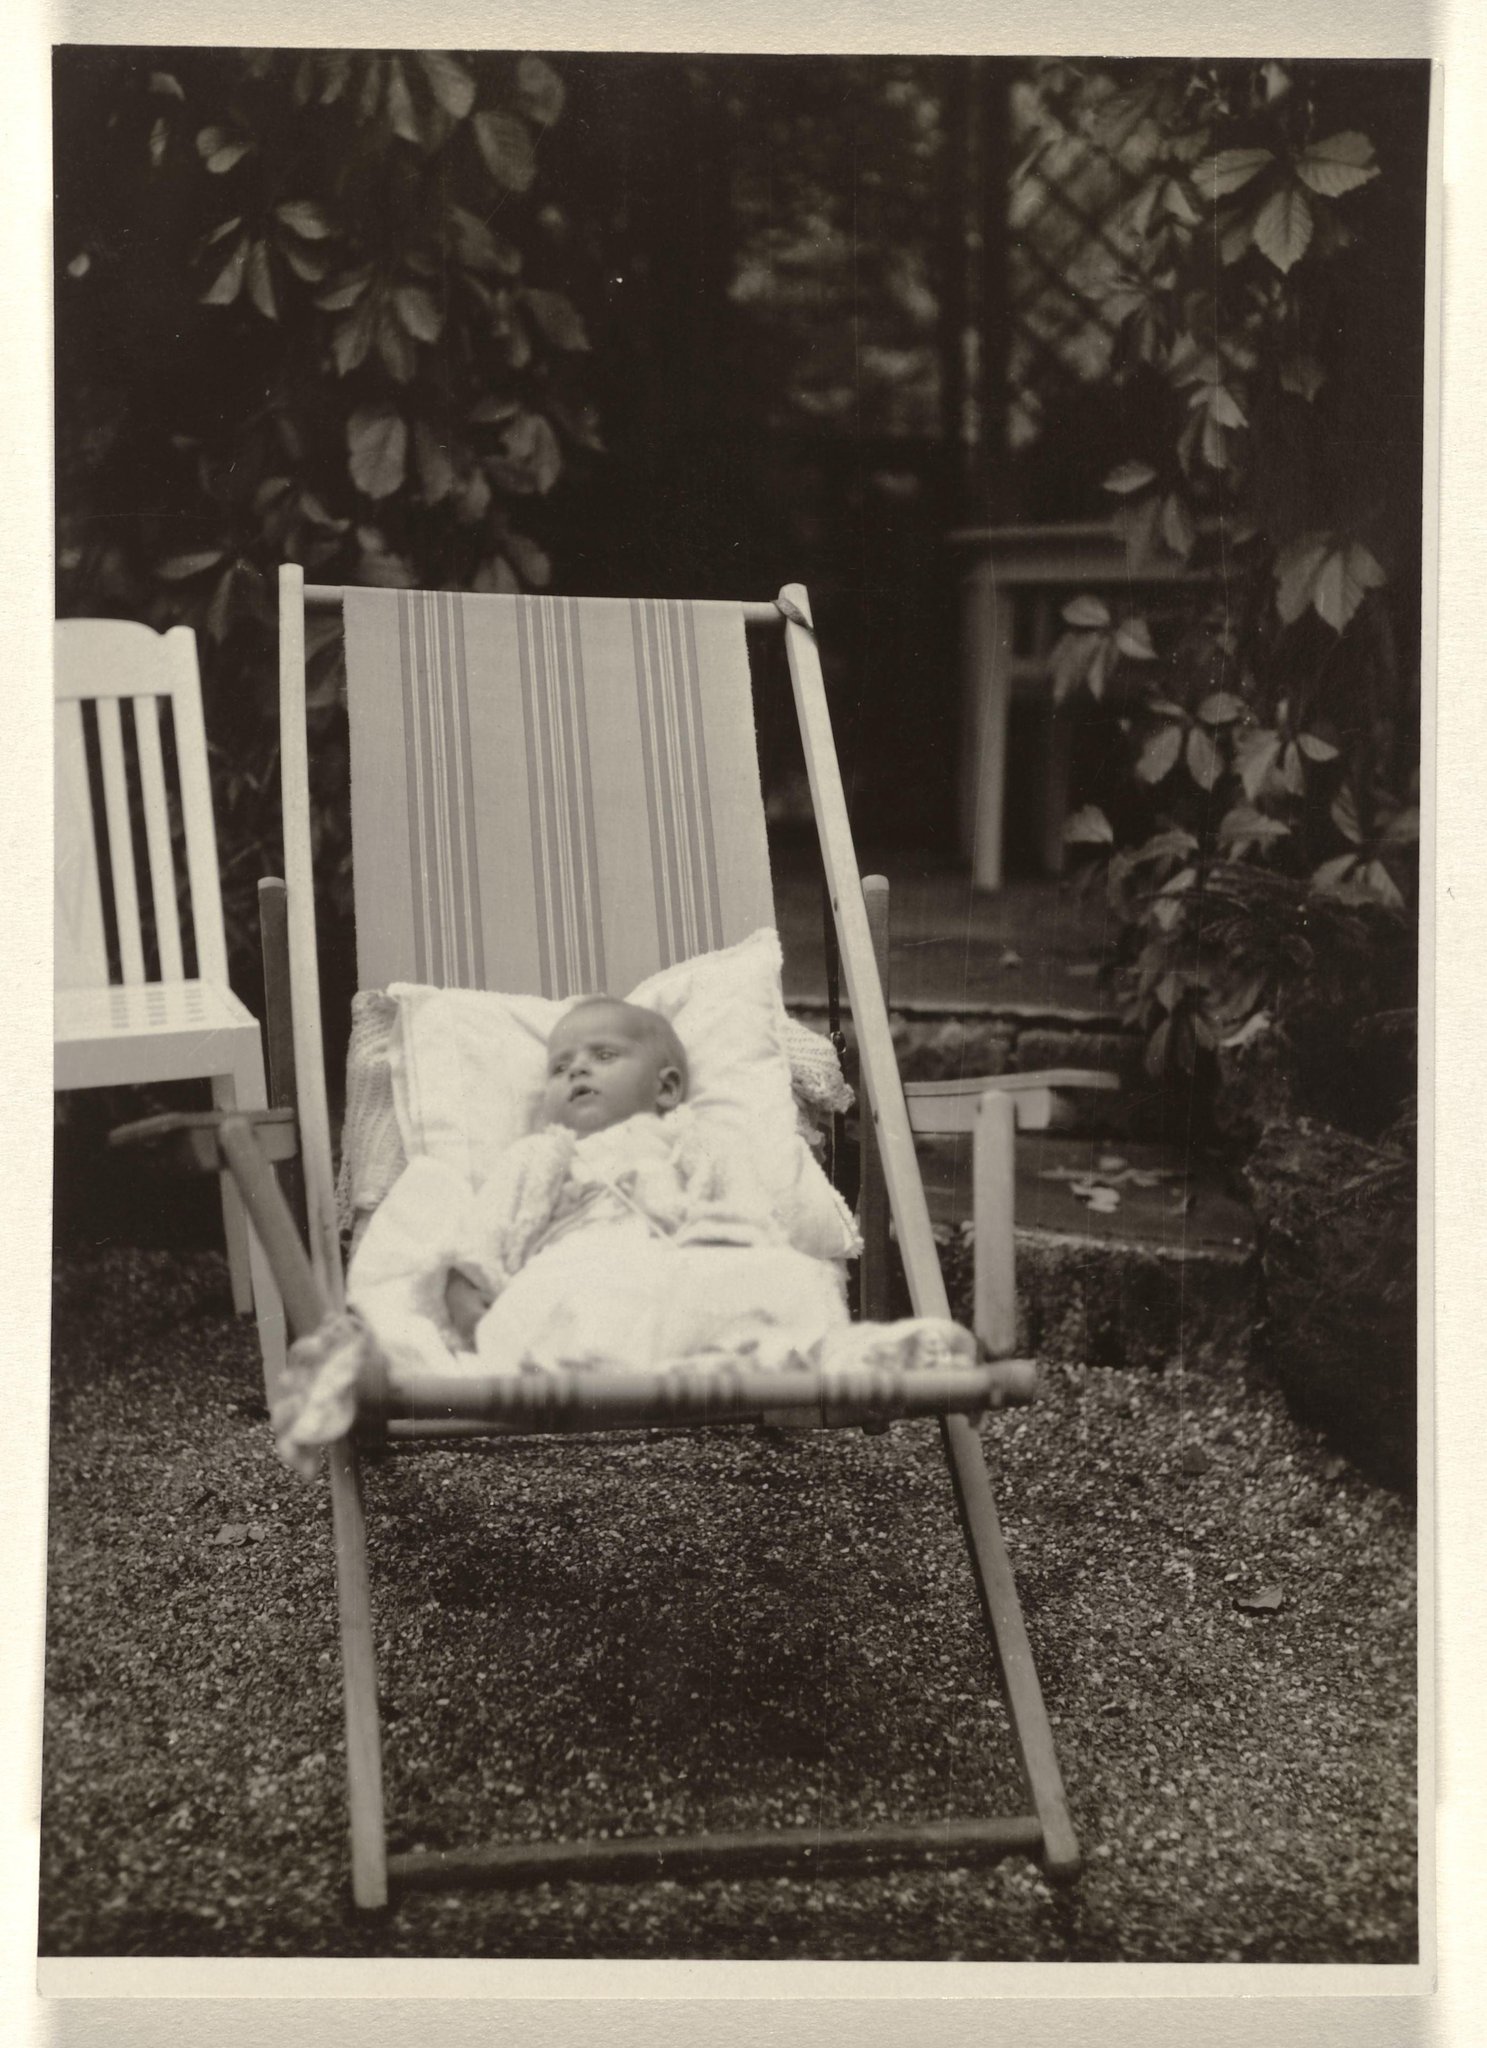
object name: photograph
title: Isabel Wachenheimer als baby in een ligstoel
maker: Anonymous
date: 1928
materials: photographic support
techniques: gelatin silver print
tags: leiden, isabel wachenheimer-elon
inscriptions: inscription: ‘Isabel Maria wünscht ihren Papi Alles Gute 10.10.28. 40’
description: Dit object is onderdeel van de nalatenschap van Isabel Elon-Wachenheimer (1928-2010). Tot haar overlijden behoorde het samen met de andere objecten uit de nalatenschap tot haar privédomein van Isabel Wachenheimer. In die particuliere context zijn deze objecten tezamen en individueel aandenkens - aan de jeugd, ouders en familie van Isabel Wachenheimer vóór en tijdens de Shoah en aan haar leven na de Tweede Wereldoorlog. Isabel Wachenheimer, die van juni 1943 tot mei 1945 gevangen zat in Kamp Westerbork, Theresienstadt, Auschwitz, Lenzing a/d Oberdonau (een buitenkamp van Mauthausen), overleefde de Shoah. Haar ouders – Eugène Wachenheimer en Else Wachenheimer-Moos - werden op 14 oktober 1944 in Auschwitz-Birkenau vermoord.